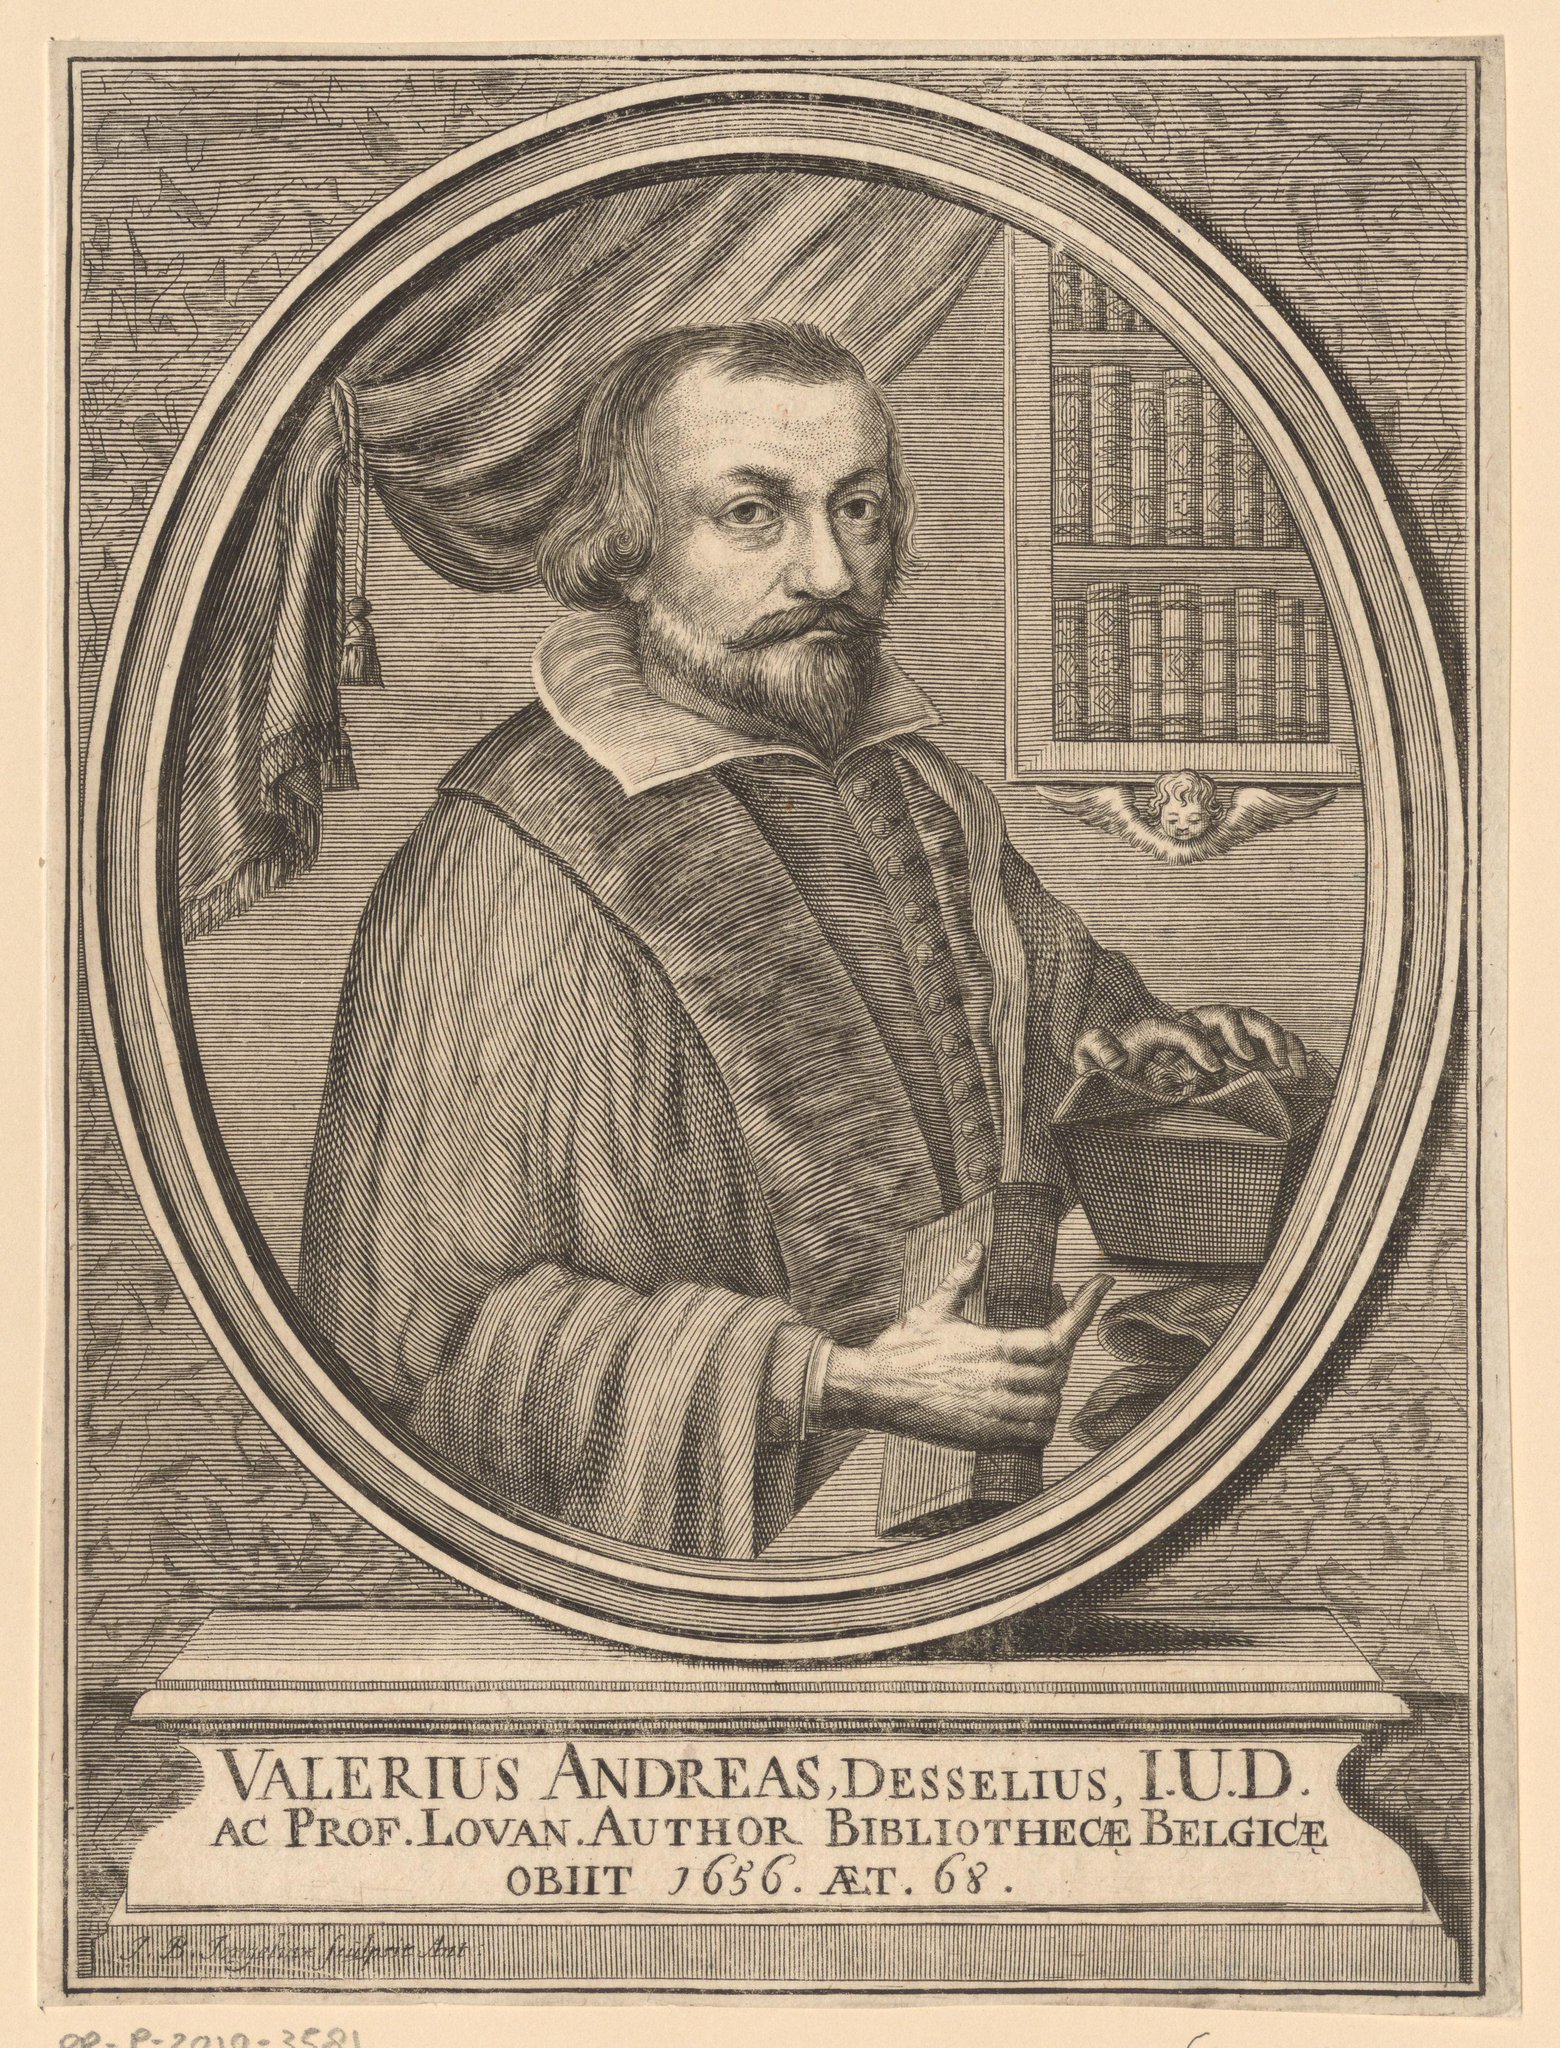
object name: book illustration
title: Portret van Valerius Andreas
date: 1700-1716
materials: paper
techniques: engraving, etching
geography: antwerp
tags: louvain, bookshelves, historical persons, book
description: Prent uit: Foppens, Johannes Franciscus. Bibliotheca belgica, sive virorum in Belgio vita, scriptisque illustrium catalogus, librorumque nomenclatura : continens scriptores (...). Brussel: Pierre Foppens, 1739, dl. 2.